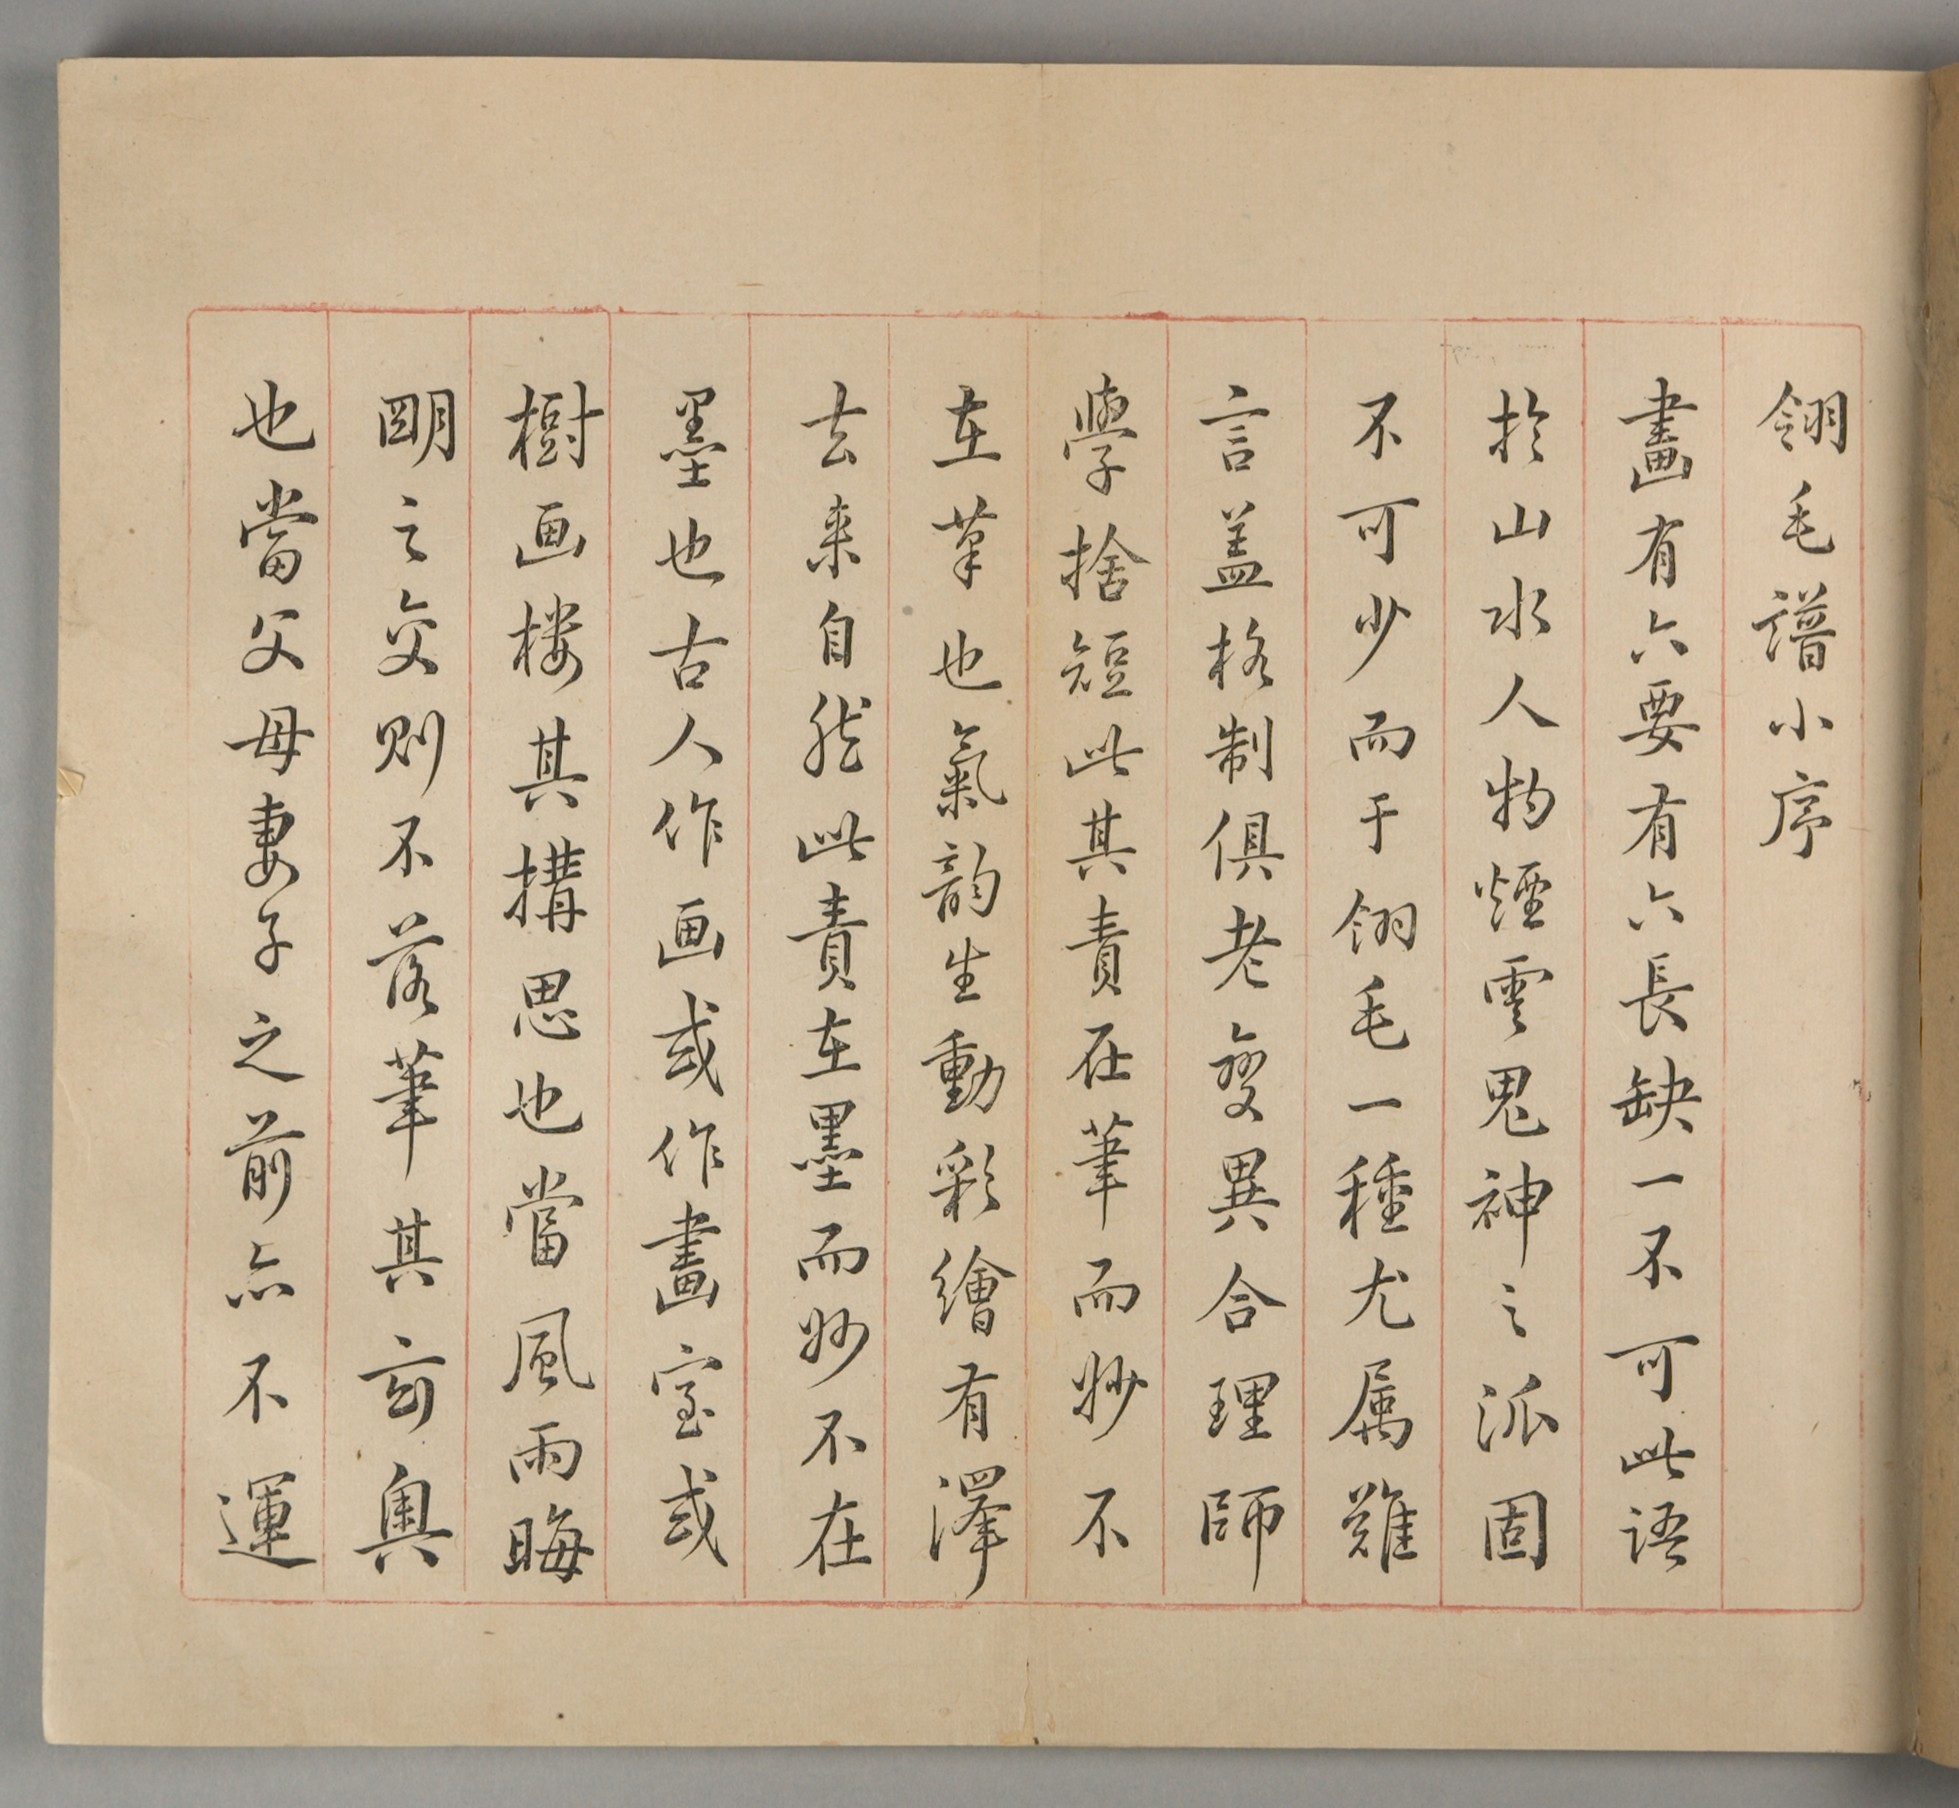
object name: illustrated book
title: Ten Bamboo Studio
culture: chinese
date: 1821-1850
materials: ink, paper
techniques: woodblock print